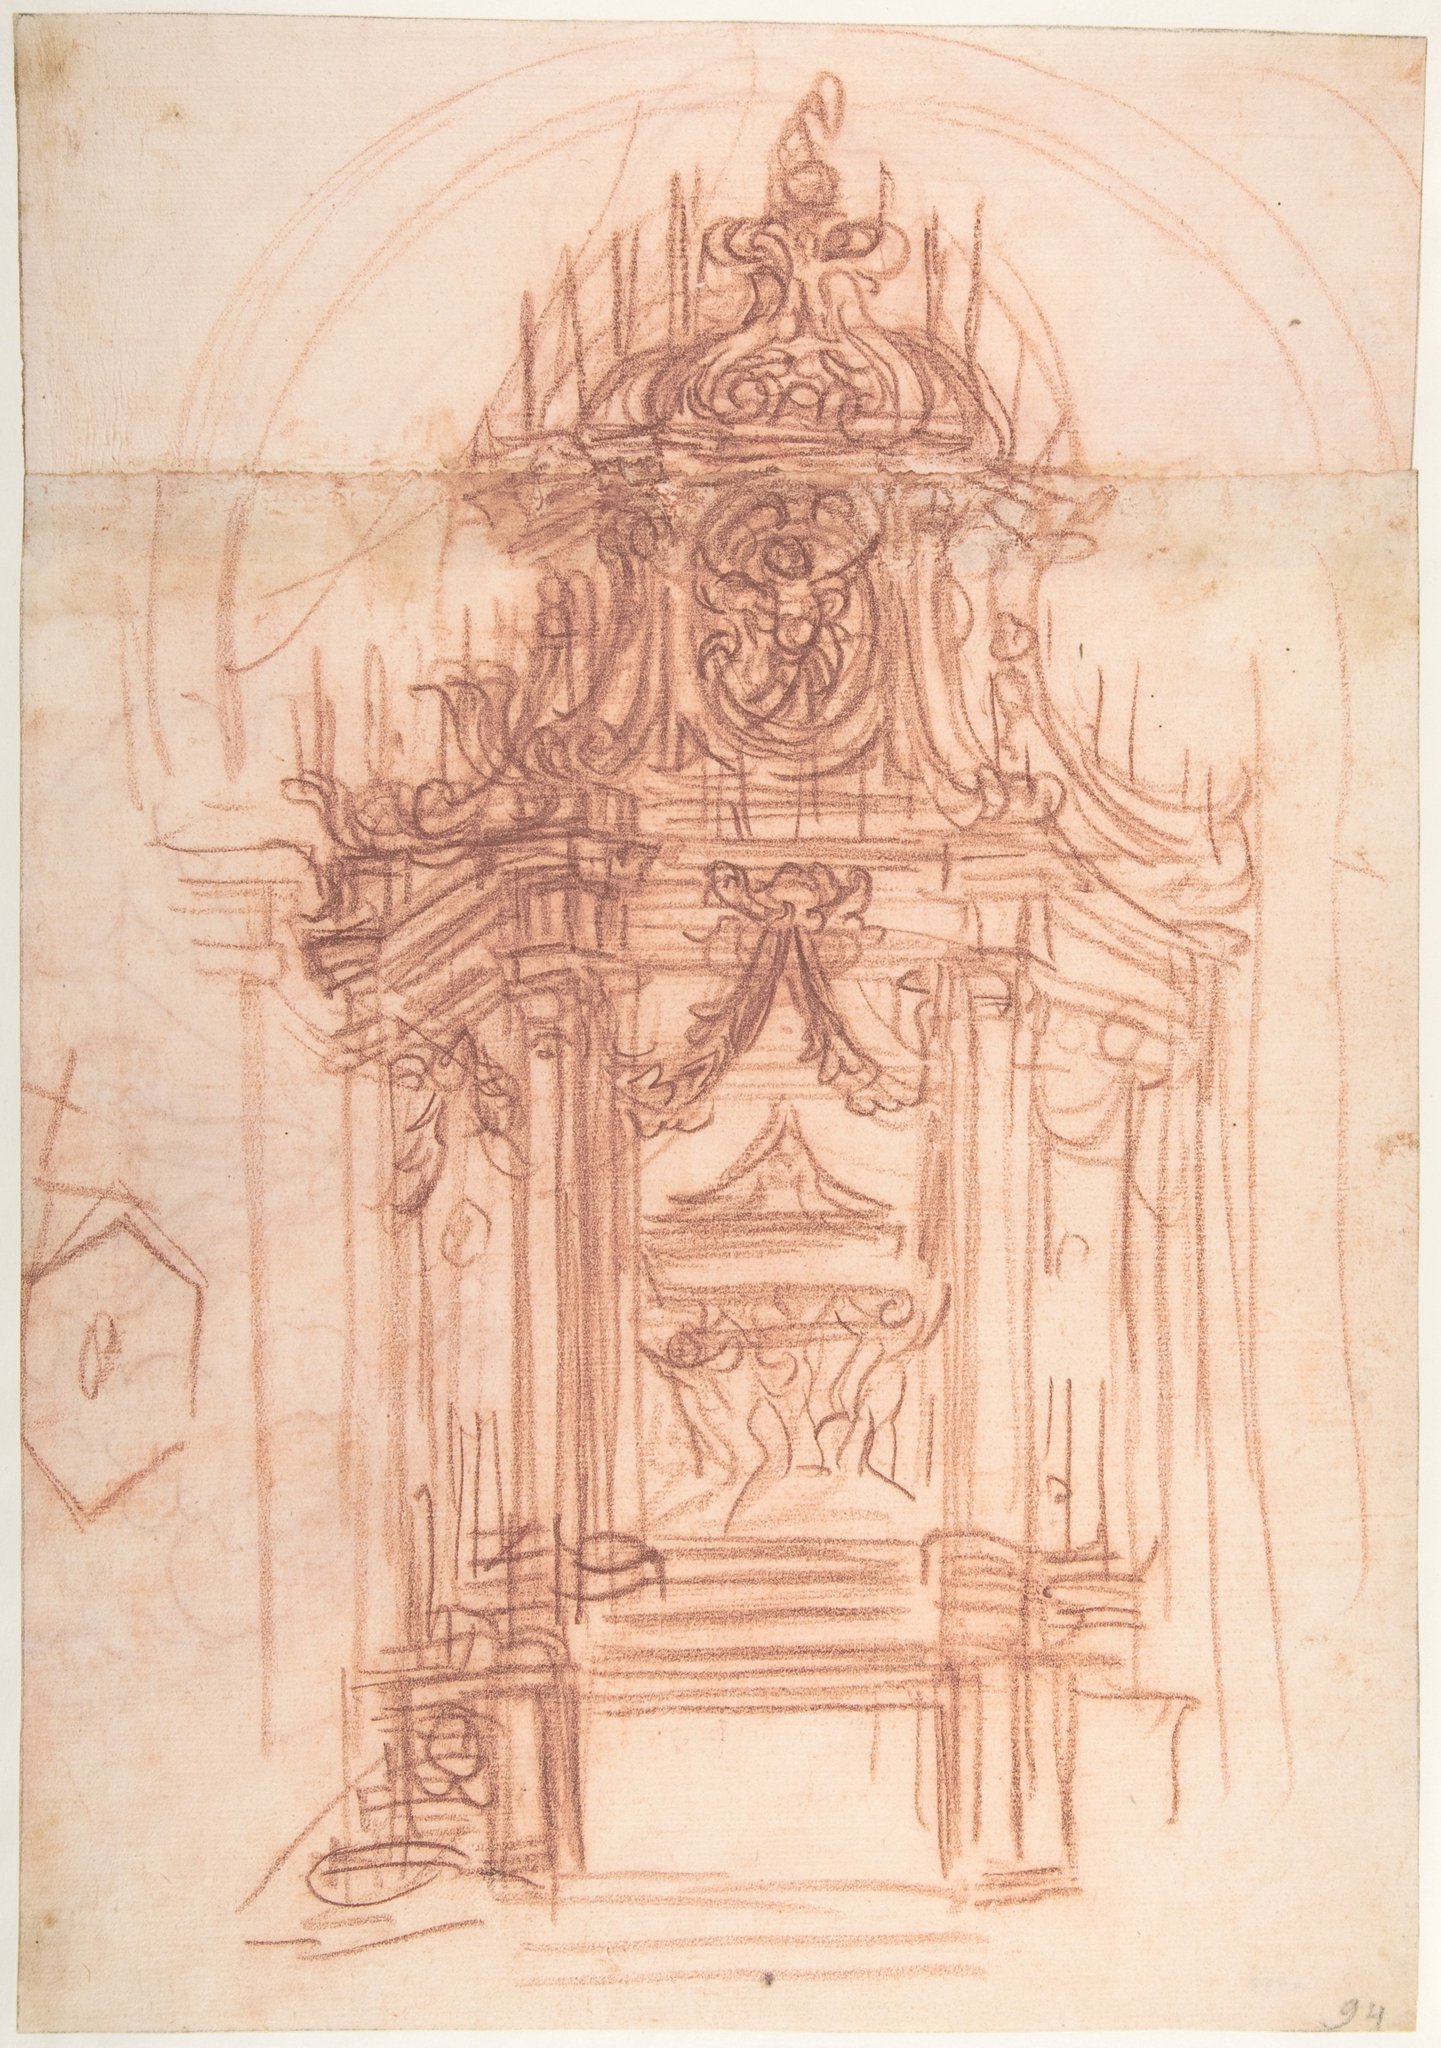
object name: drawing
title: Design for a Catafalque (recto); Female Saint Kneeling on Clouds under an Arch, and a Design for the Pinnacle of the Catafalque (verso)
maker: baldassarre franceschini (il volterrano)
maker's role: artist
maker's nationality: italian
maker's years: 1611-1690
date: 1669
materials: chalk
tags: architecture